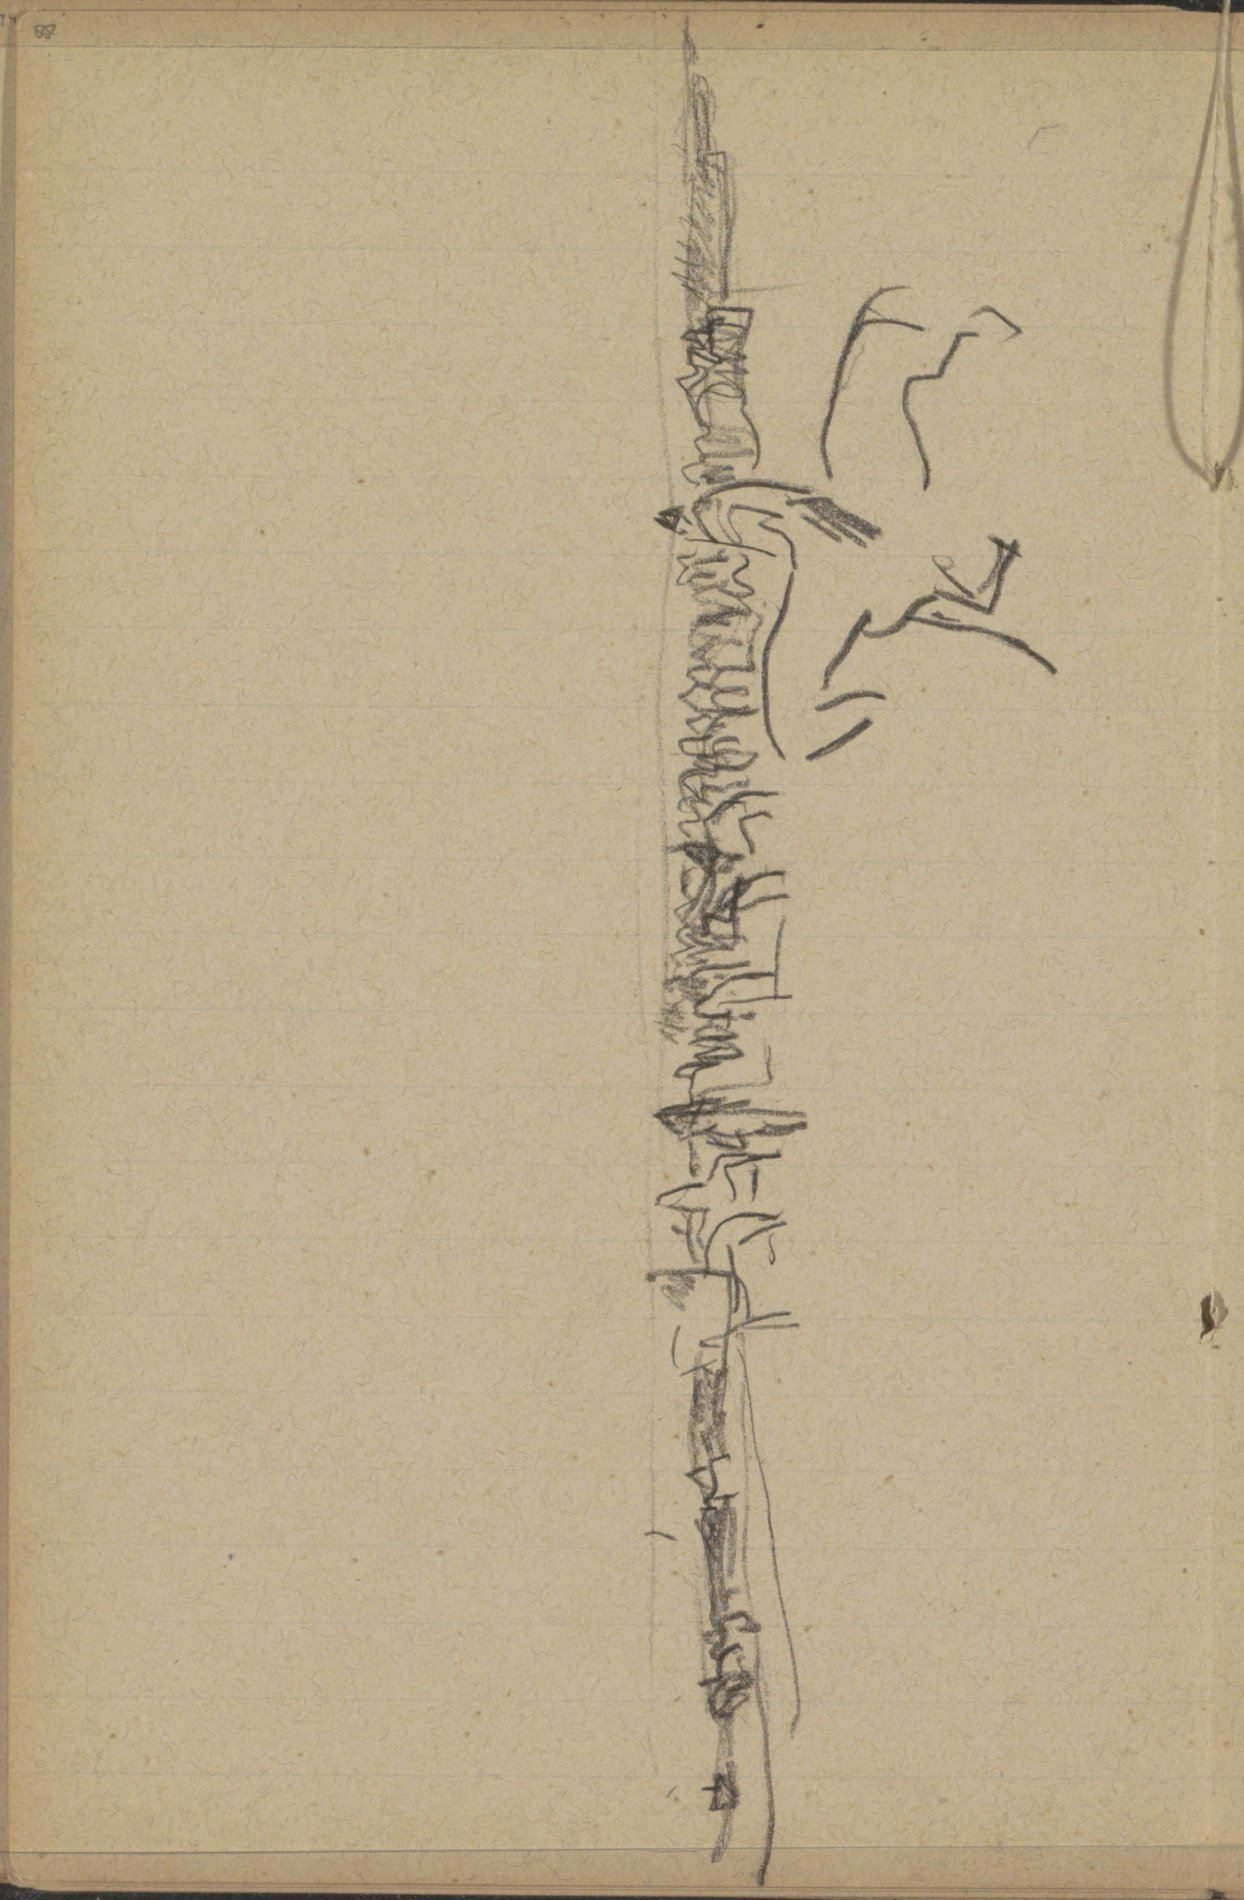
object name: sketchbook leaf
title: Landschap met ruiters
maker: marius bauer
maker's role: draughtsman, print maker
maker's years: 1867-1932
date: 1896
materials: chalk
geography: russia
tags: riding a horse, ass, or mule; rider, horseman, landscapes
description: Pagina 88 uit een schetsboek met 50 bladen.